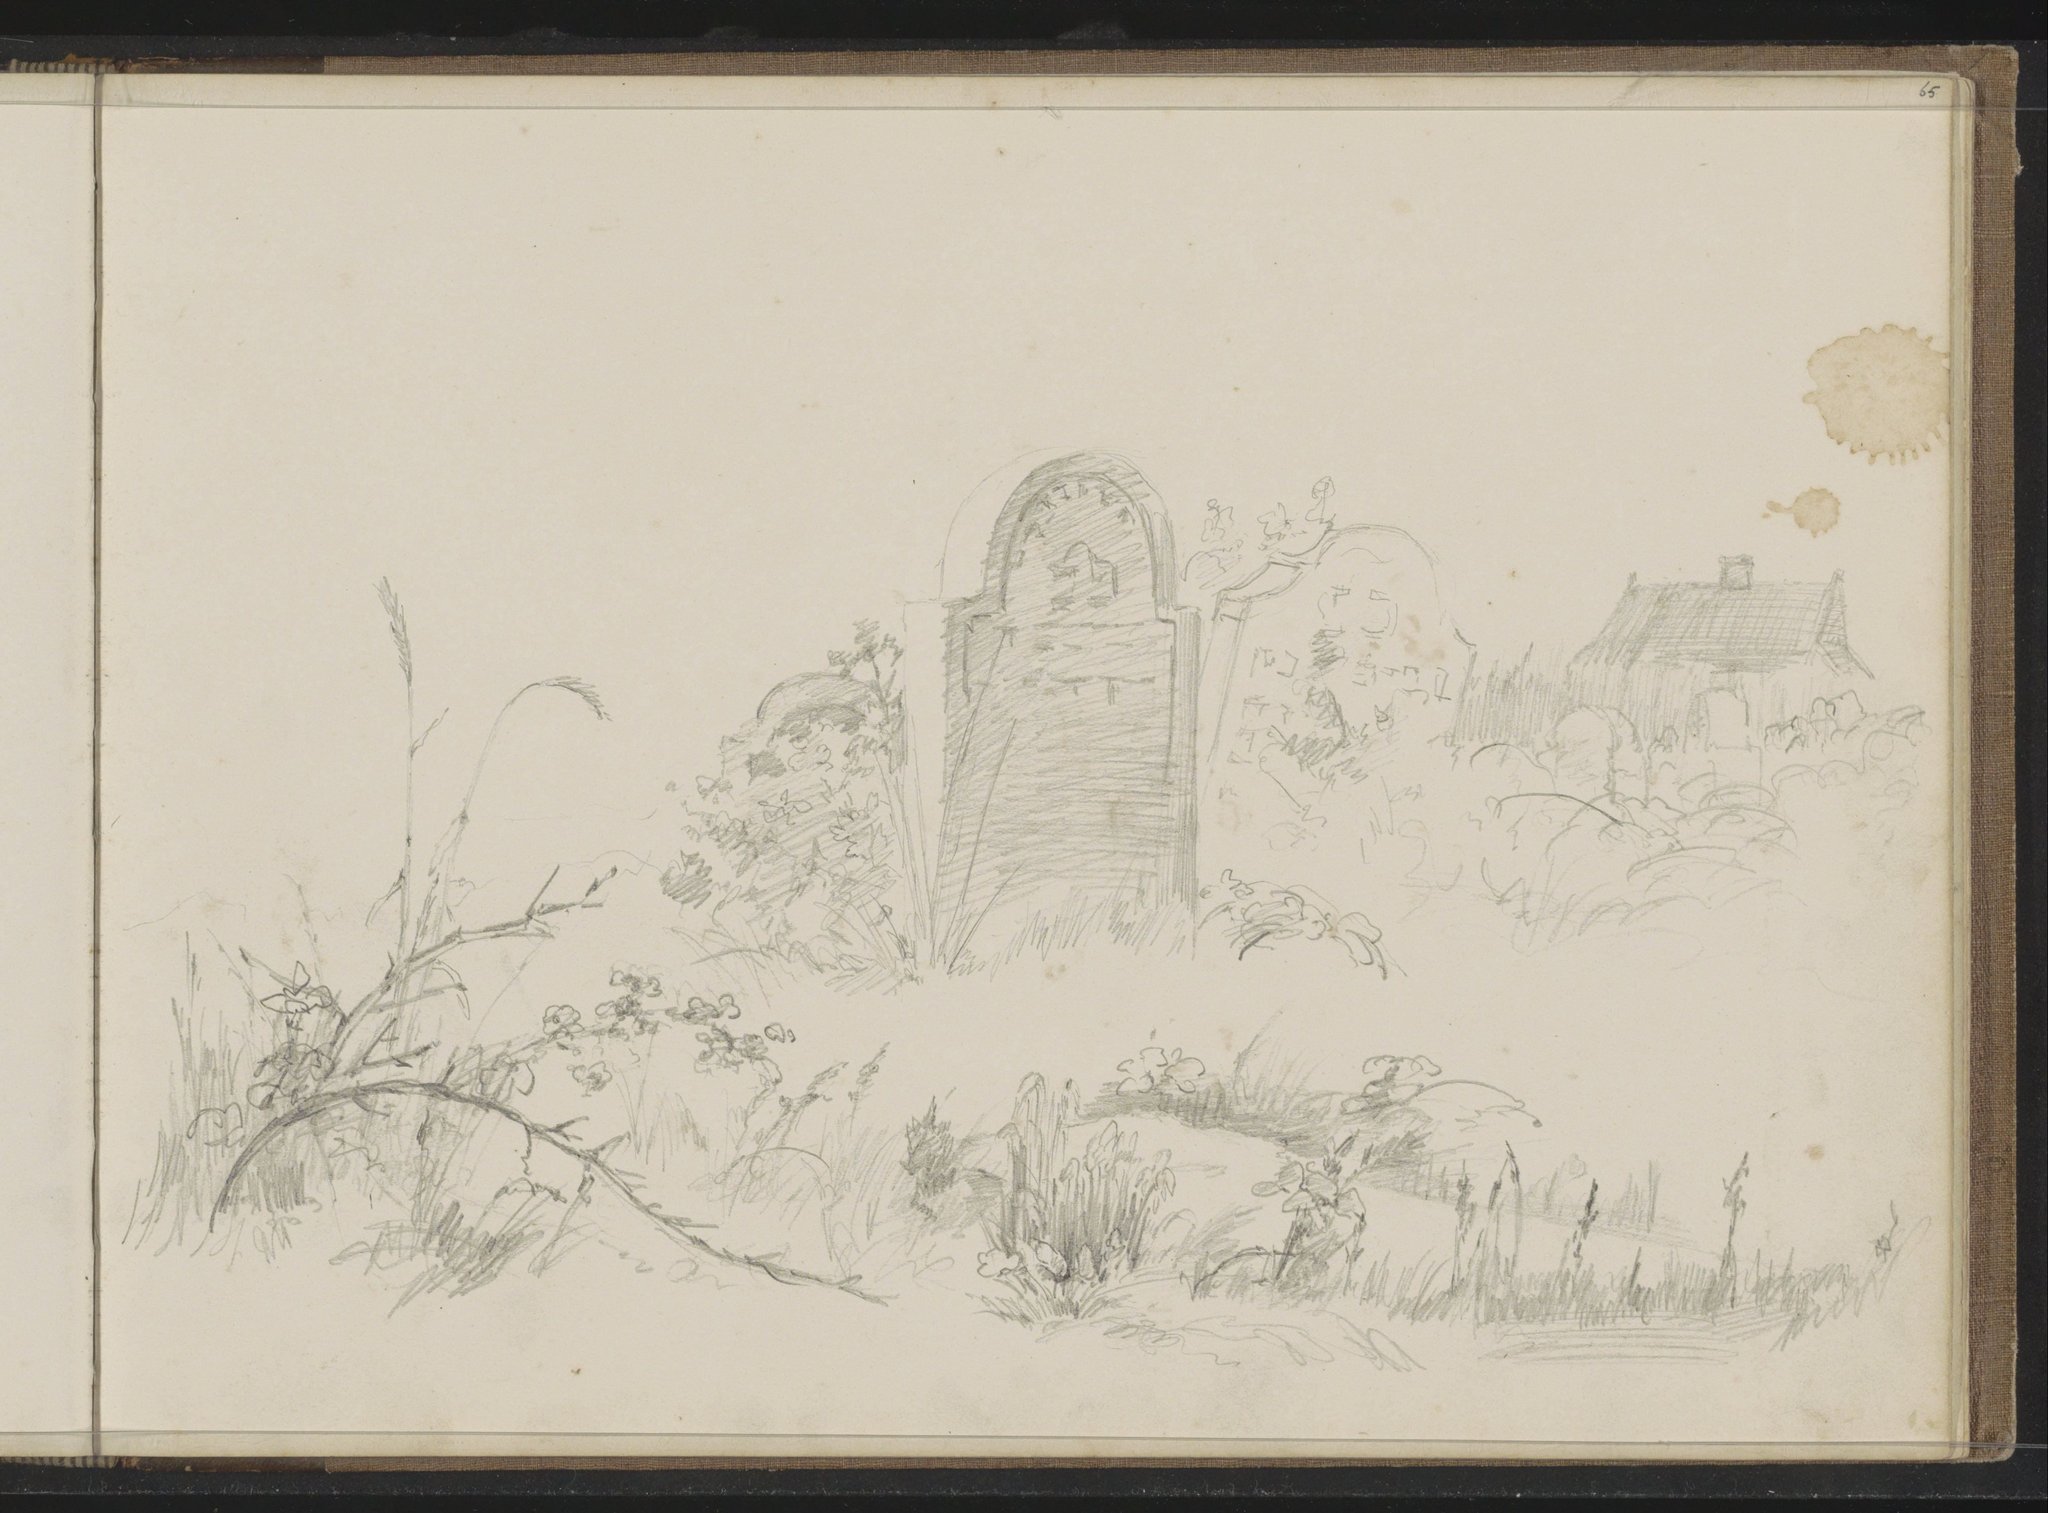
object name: sketchbook leaf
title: Grafstenen in een veld met bloemen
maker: hendrik valkenburg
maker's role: draughtsman, painter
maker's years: 1826-1896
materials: paper, pencil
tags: upright gravestone, meadow, pasture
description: Op de achtergrond een plattelandswoning. Blad 65 recto uit een schetsboek met 77 bladen.